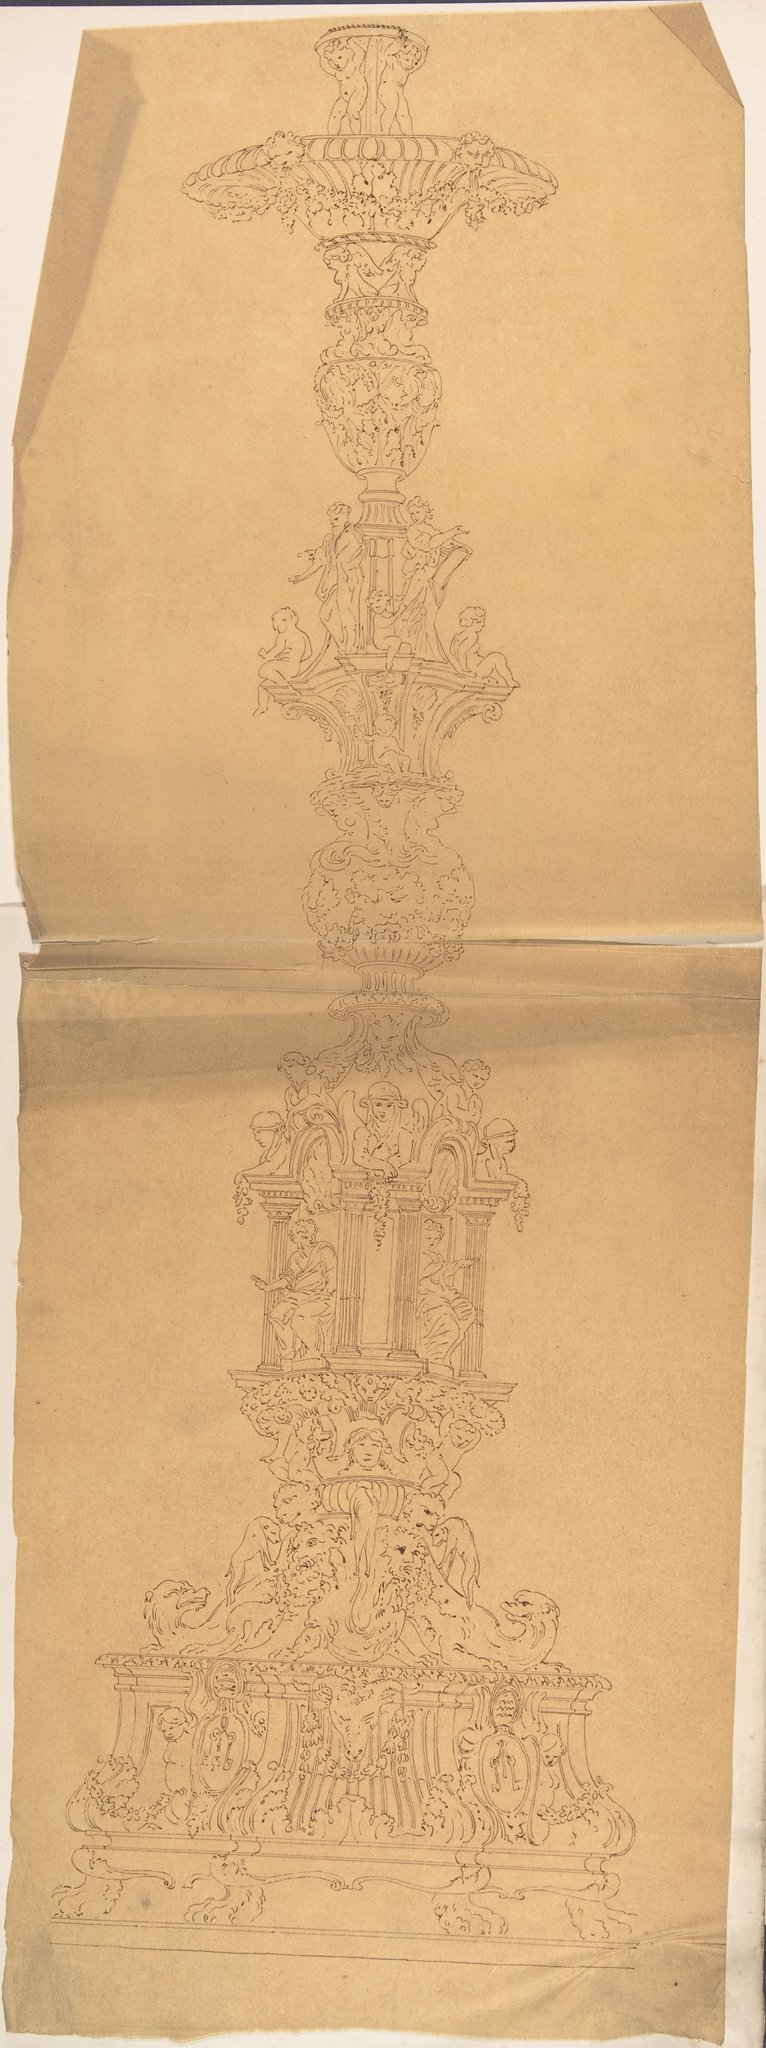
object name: drawing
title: Metal Candlestick with Classical Ornament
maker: anonymous, british, 19th century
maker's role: artist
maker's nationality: british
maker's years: 1800-1900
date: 1801-1900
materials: ink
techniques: pen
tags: candlesticks